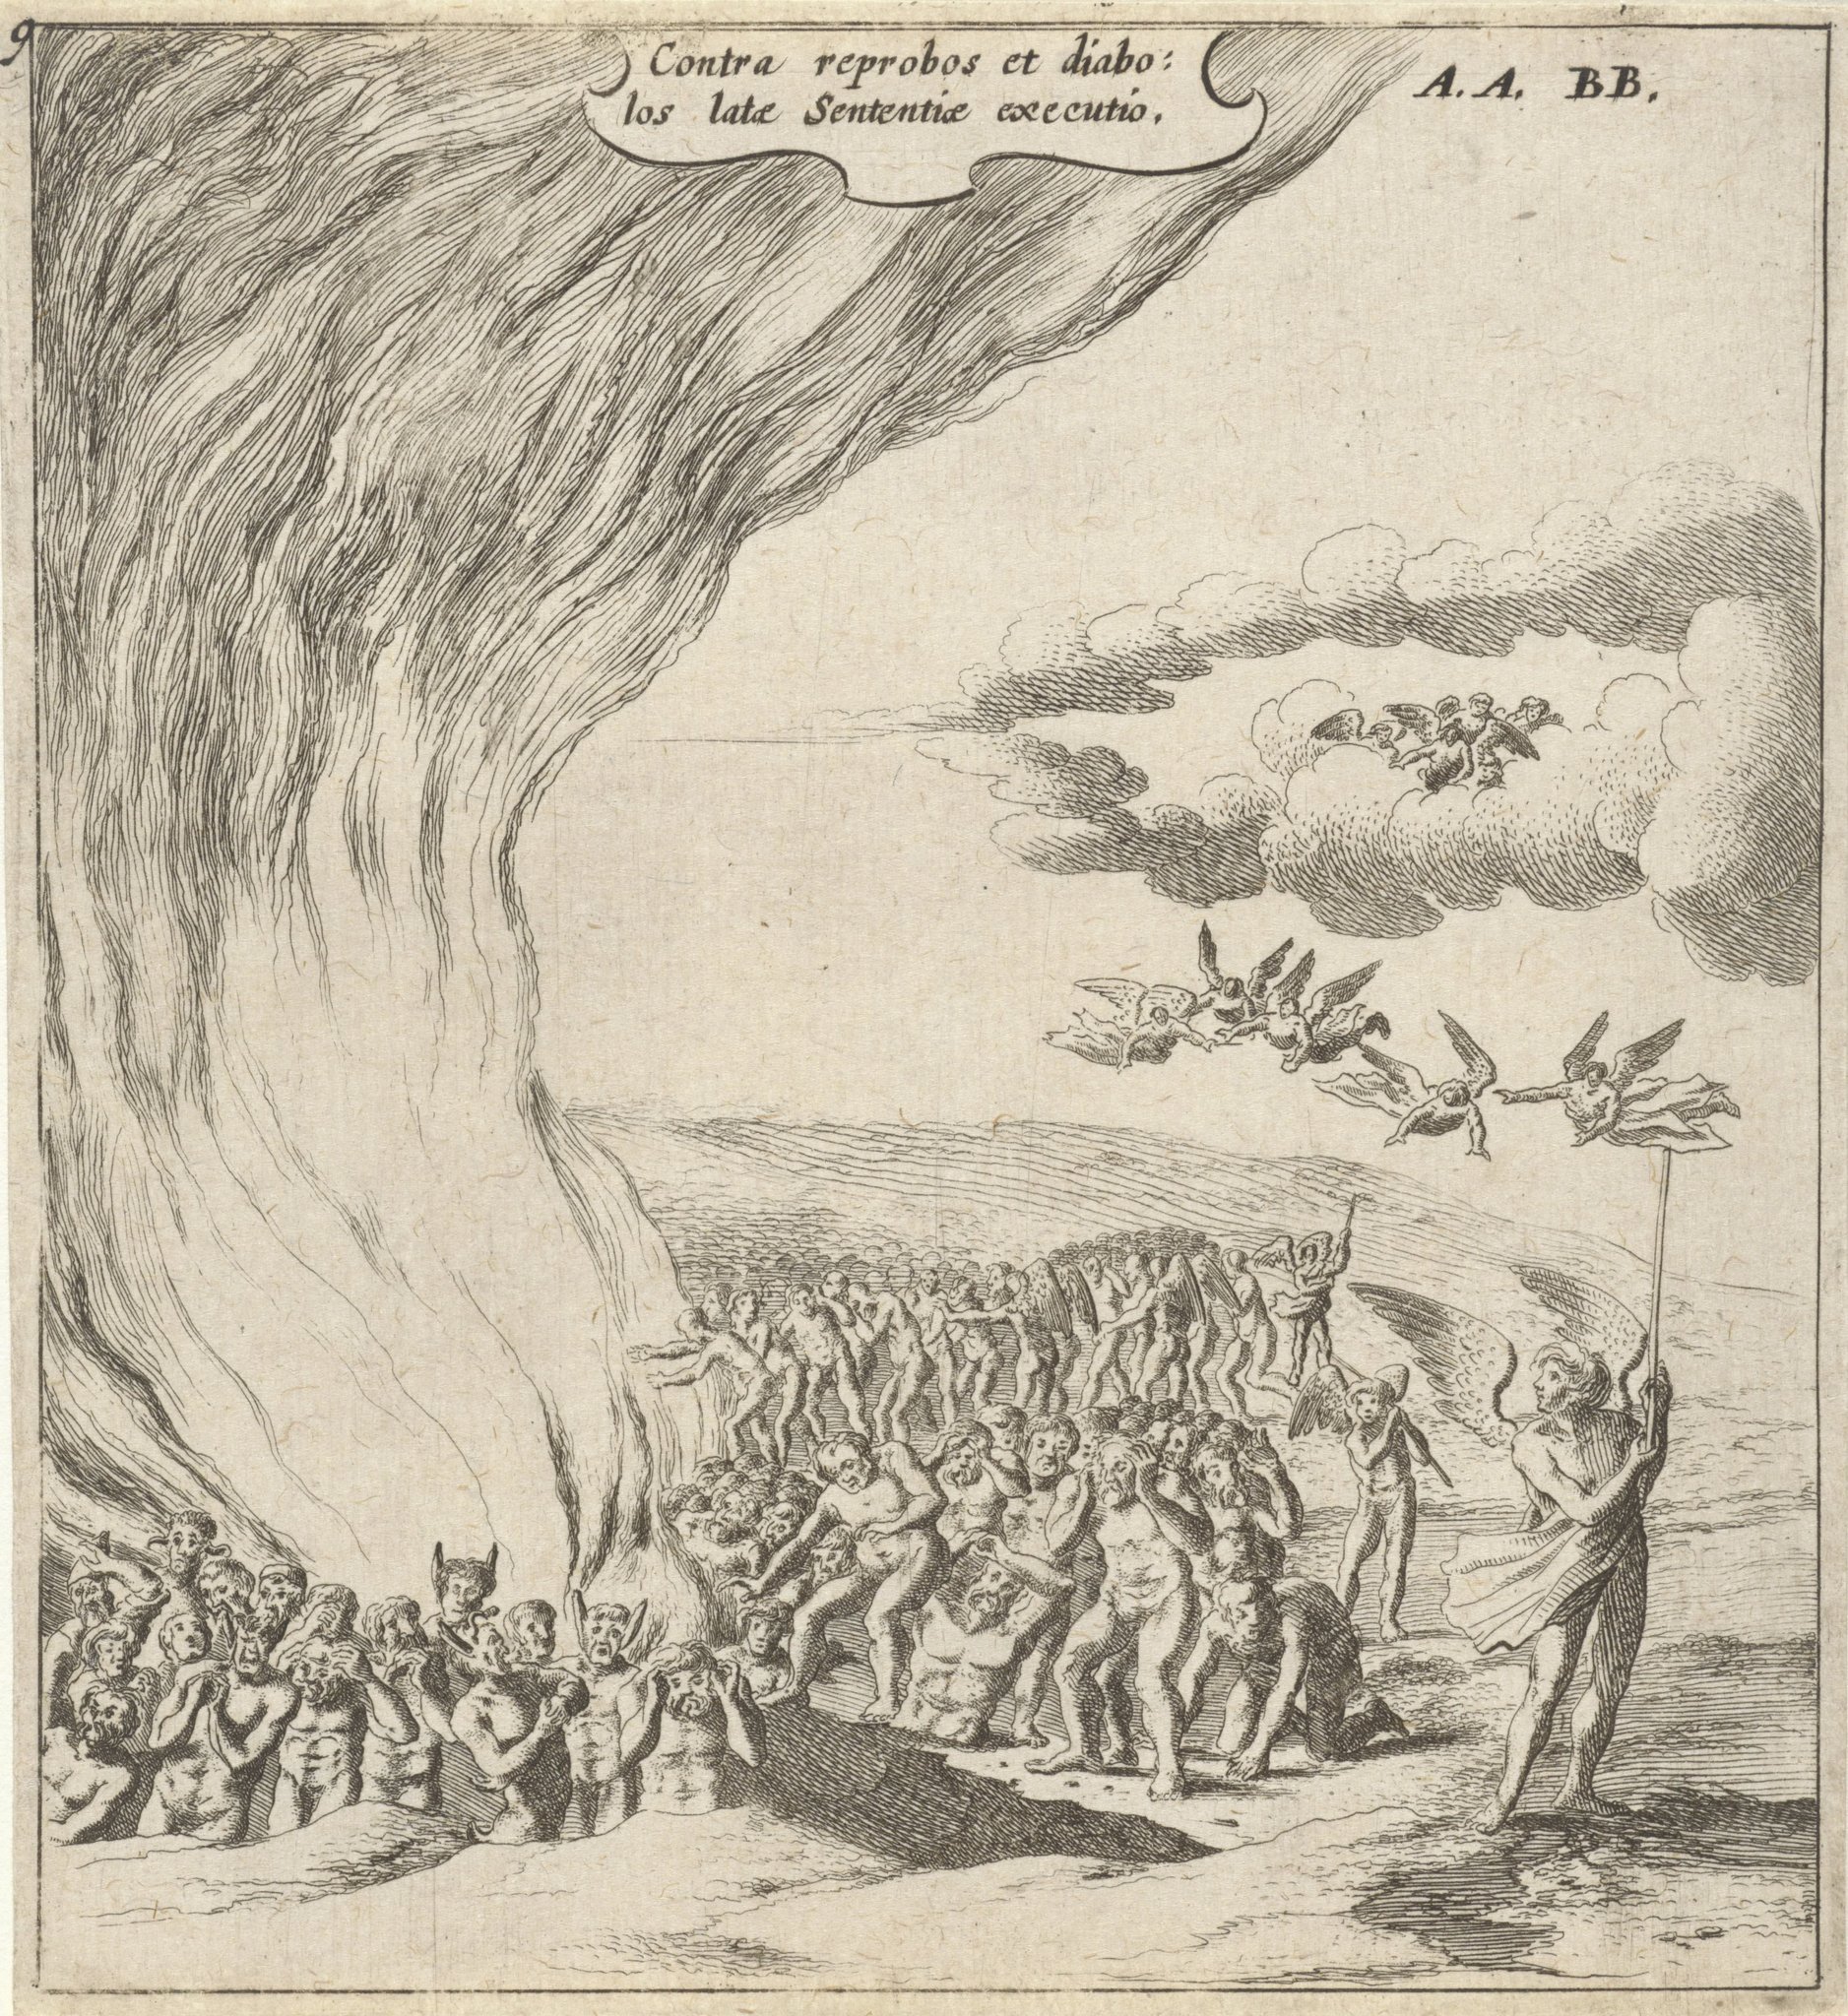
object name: book illustration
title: Verdoemden naar de hel geleid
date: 1625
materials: paper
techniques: etching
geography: haarlem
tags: last judgement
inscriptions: collector's mark: Lugt 2228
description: Illustratie in: Peil, Johann. Tabula processum seu ordinem ultimi divini et criminalis judicii exhibens. Kleef: Gerhardus Verstegen, 1625, p. 66.